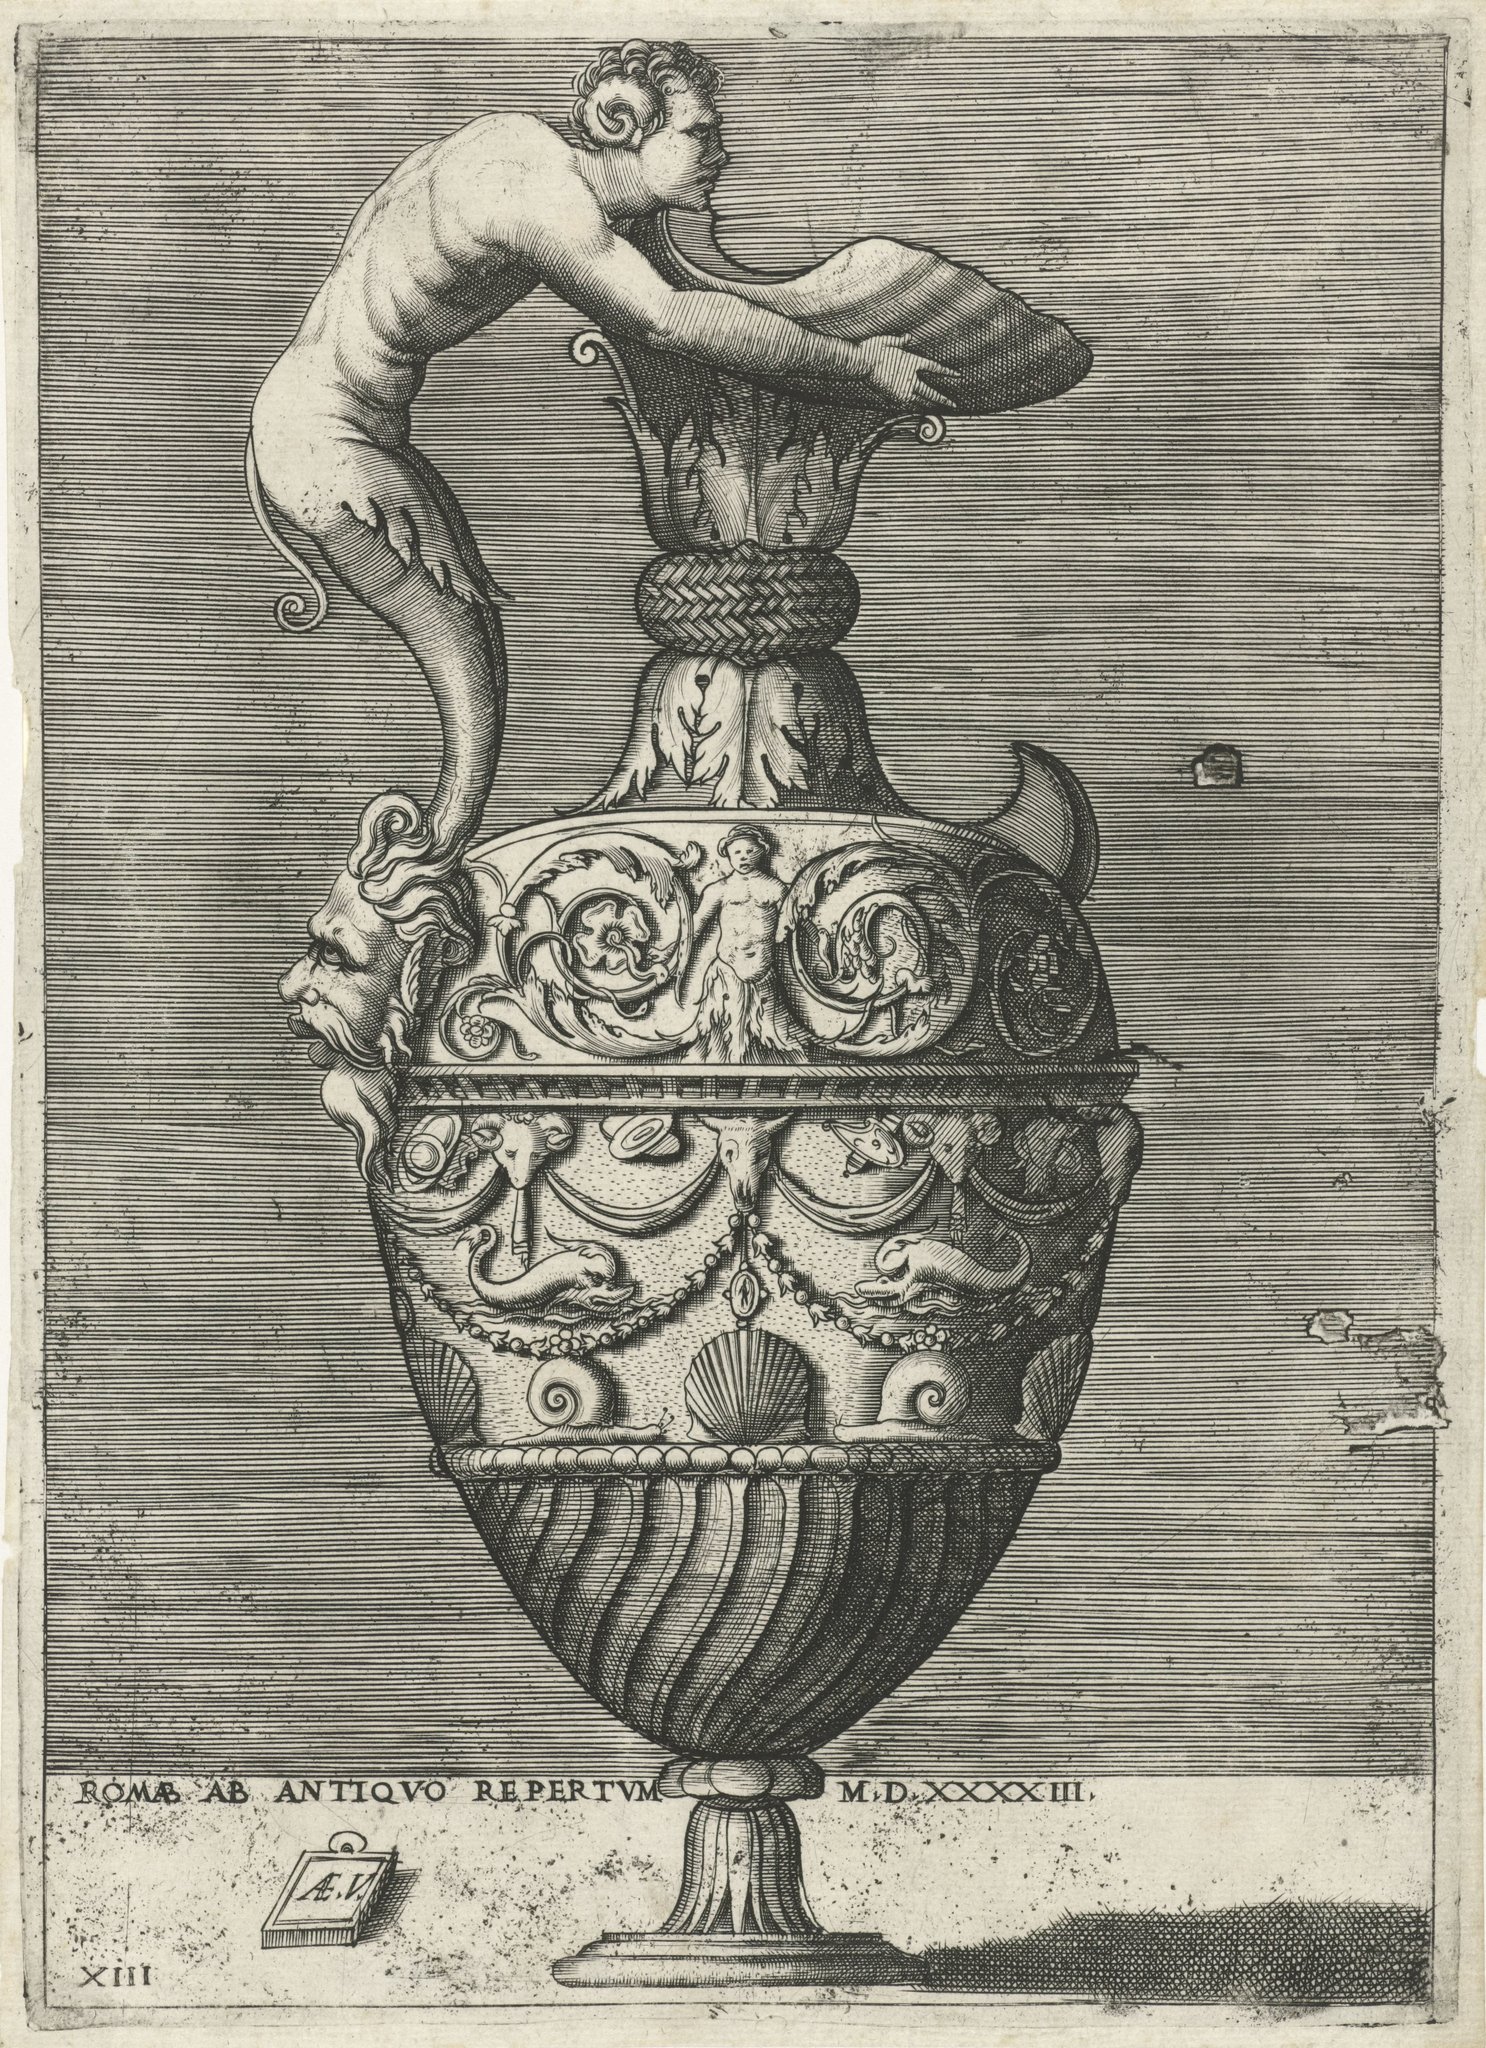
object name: ornament print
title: Kan met een oor in de vorm van een sater die staat op een mascaron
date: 1533-1567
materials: paper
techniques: engraving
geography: italy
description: Uit serie van 14 deels genummerde bladen. De vazen hebben vermoedelijk antieke vazen als uitgangspunt gehad.